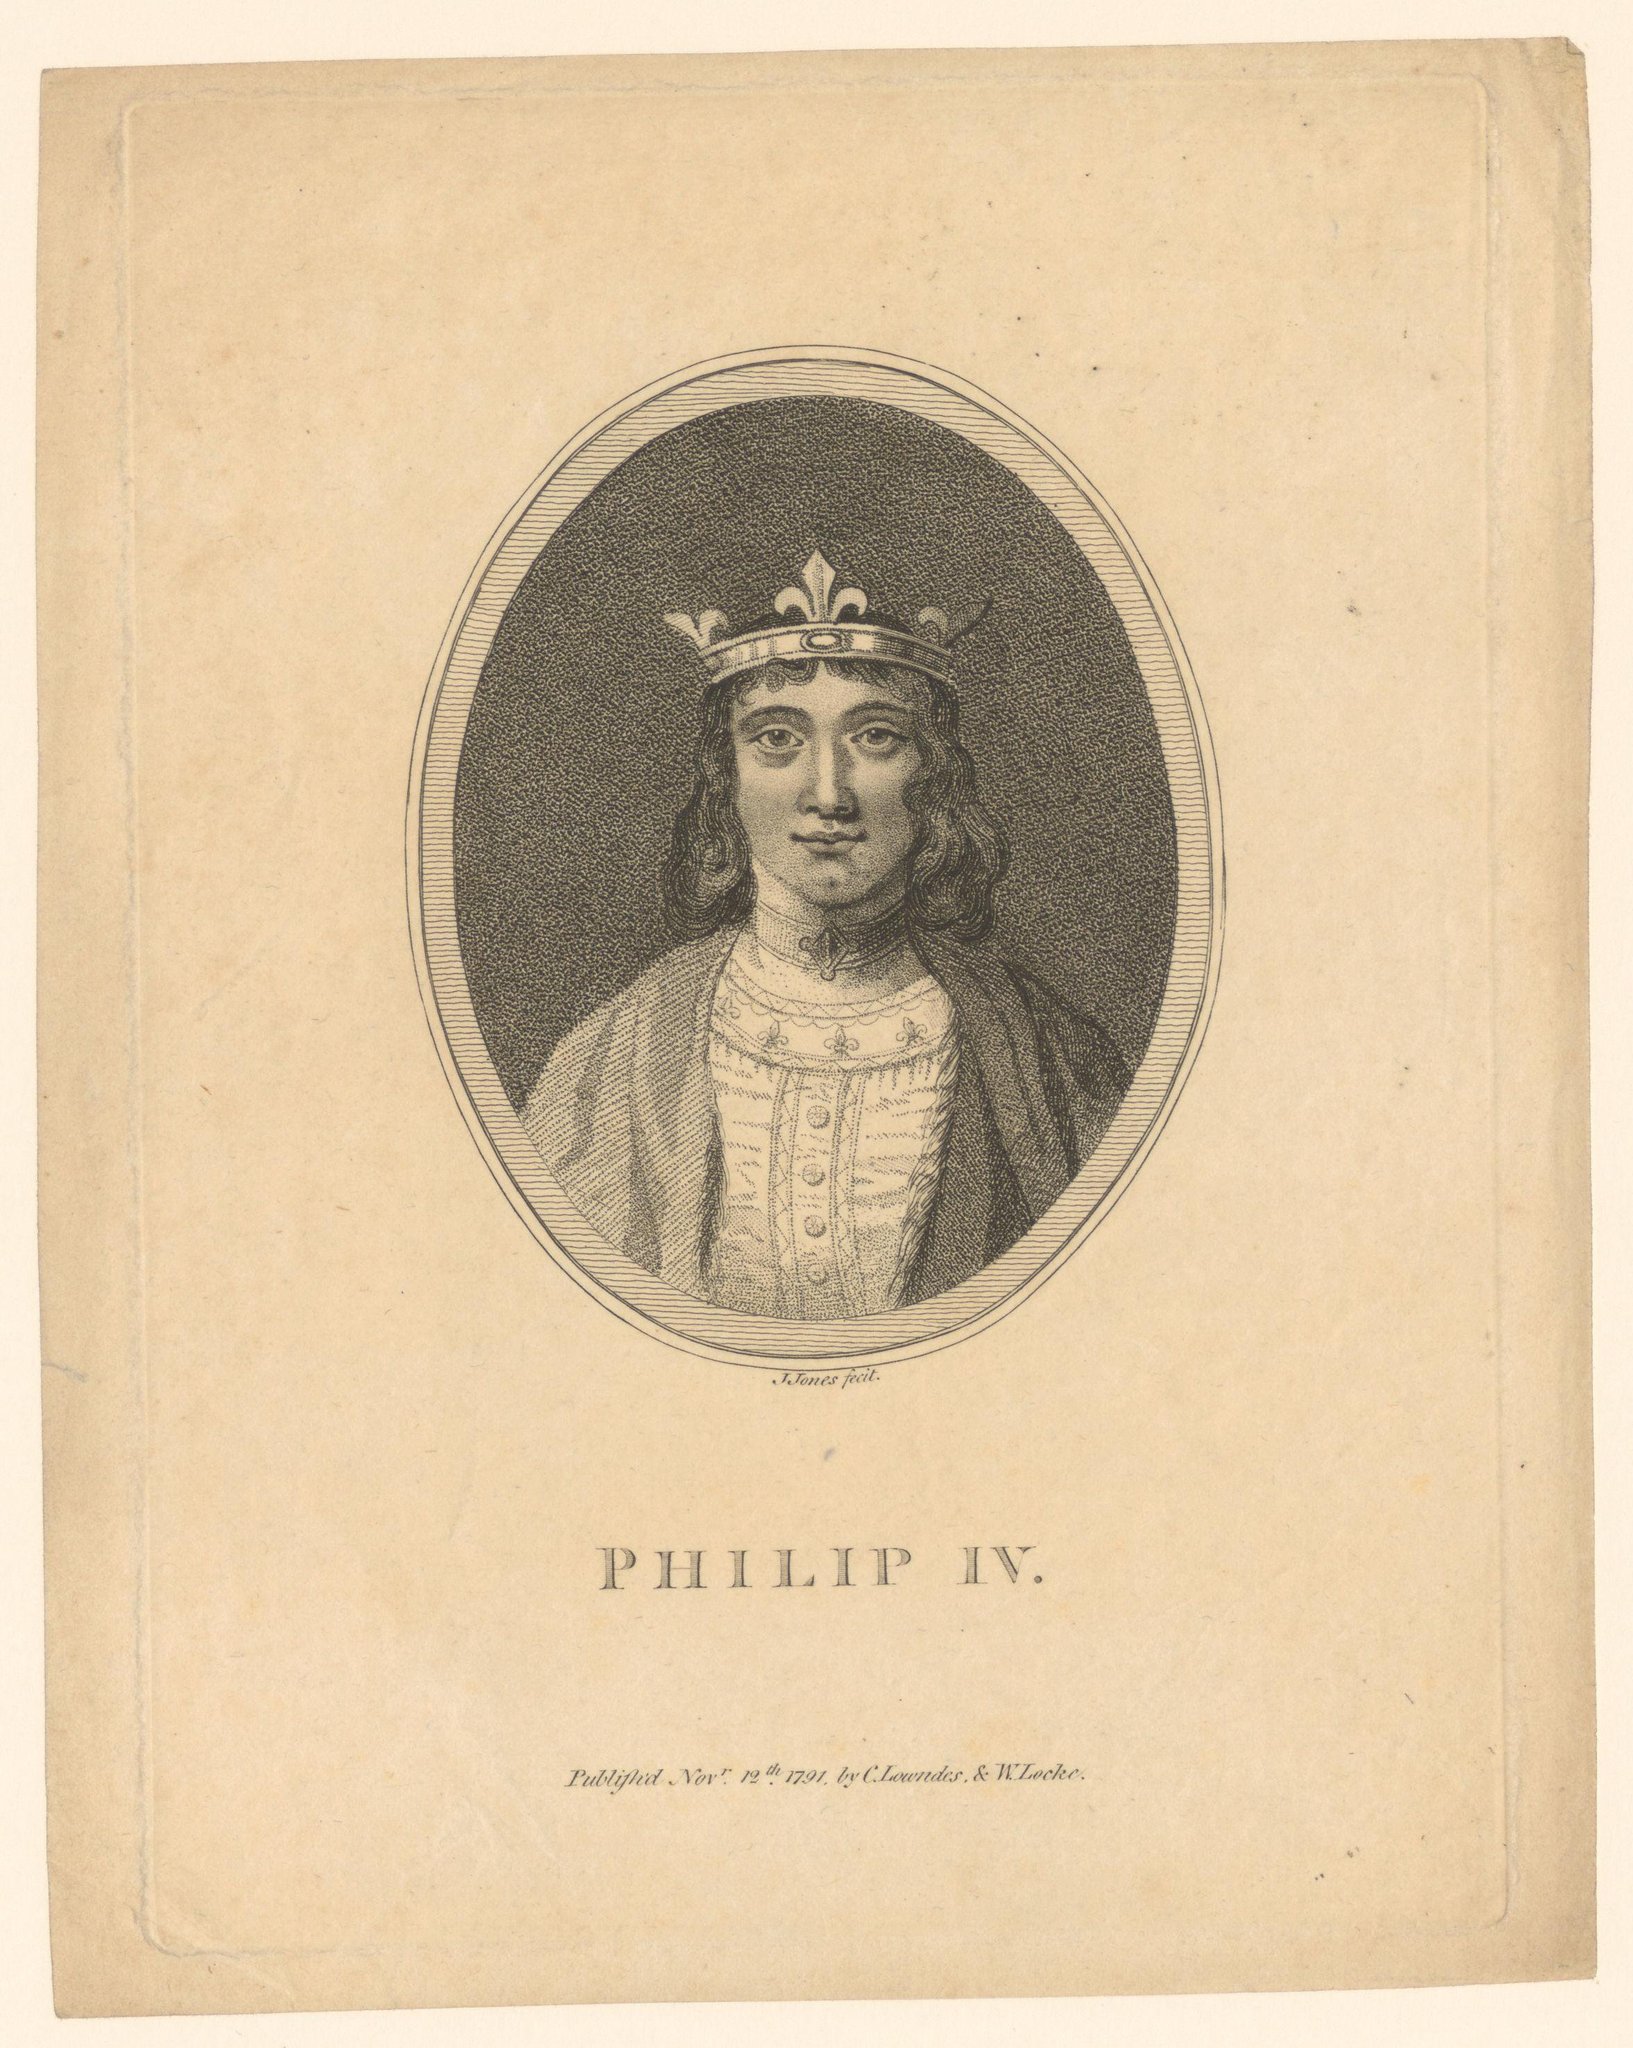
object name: print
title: Portret van Filips IV, koning van Frankrijk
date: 1791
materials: paper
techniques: etching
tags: historical persons, king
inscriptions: collector's mark: Lugt 2228